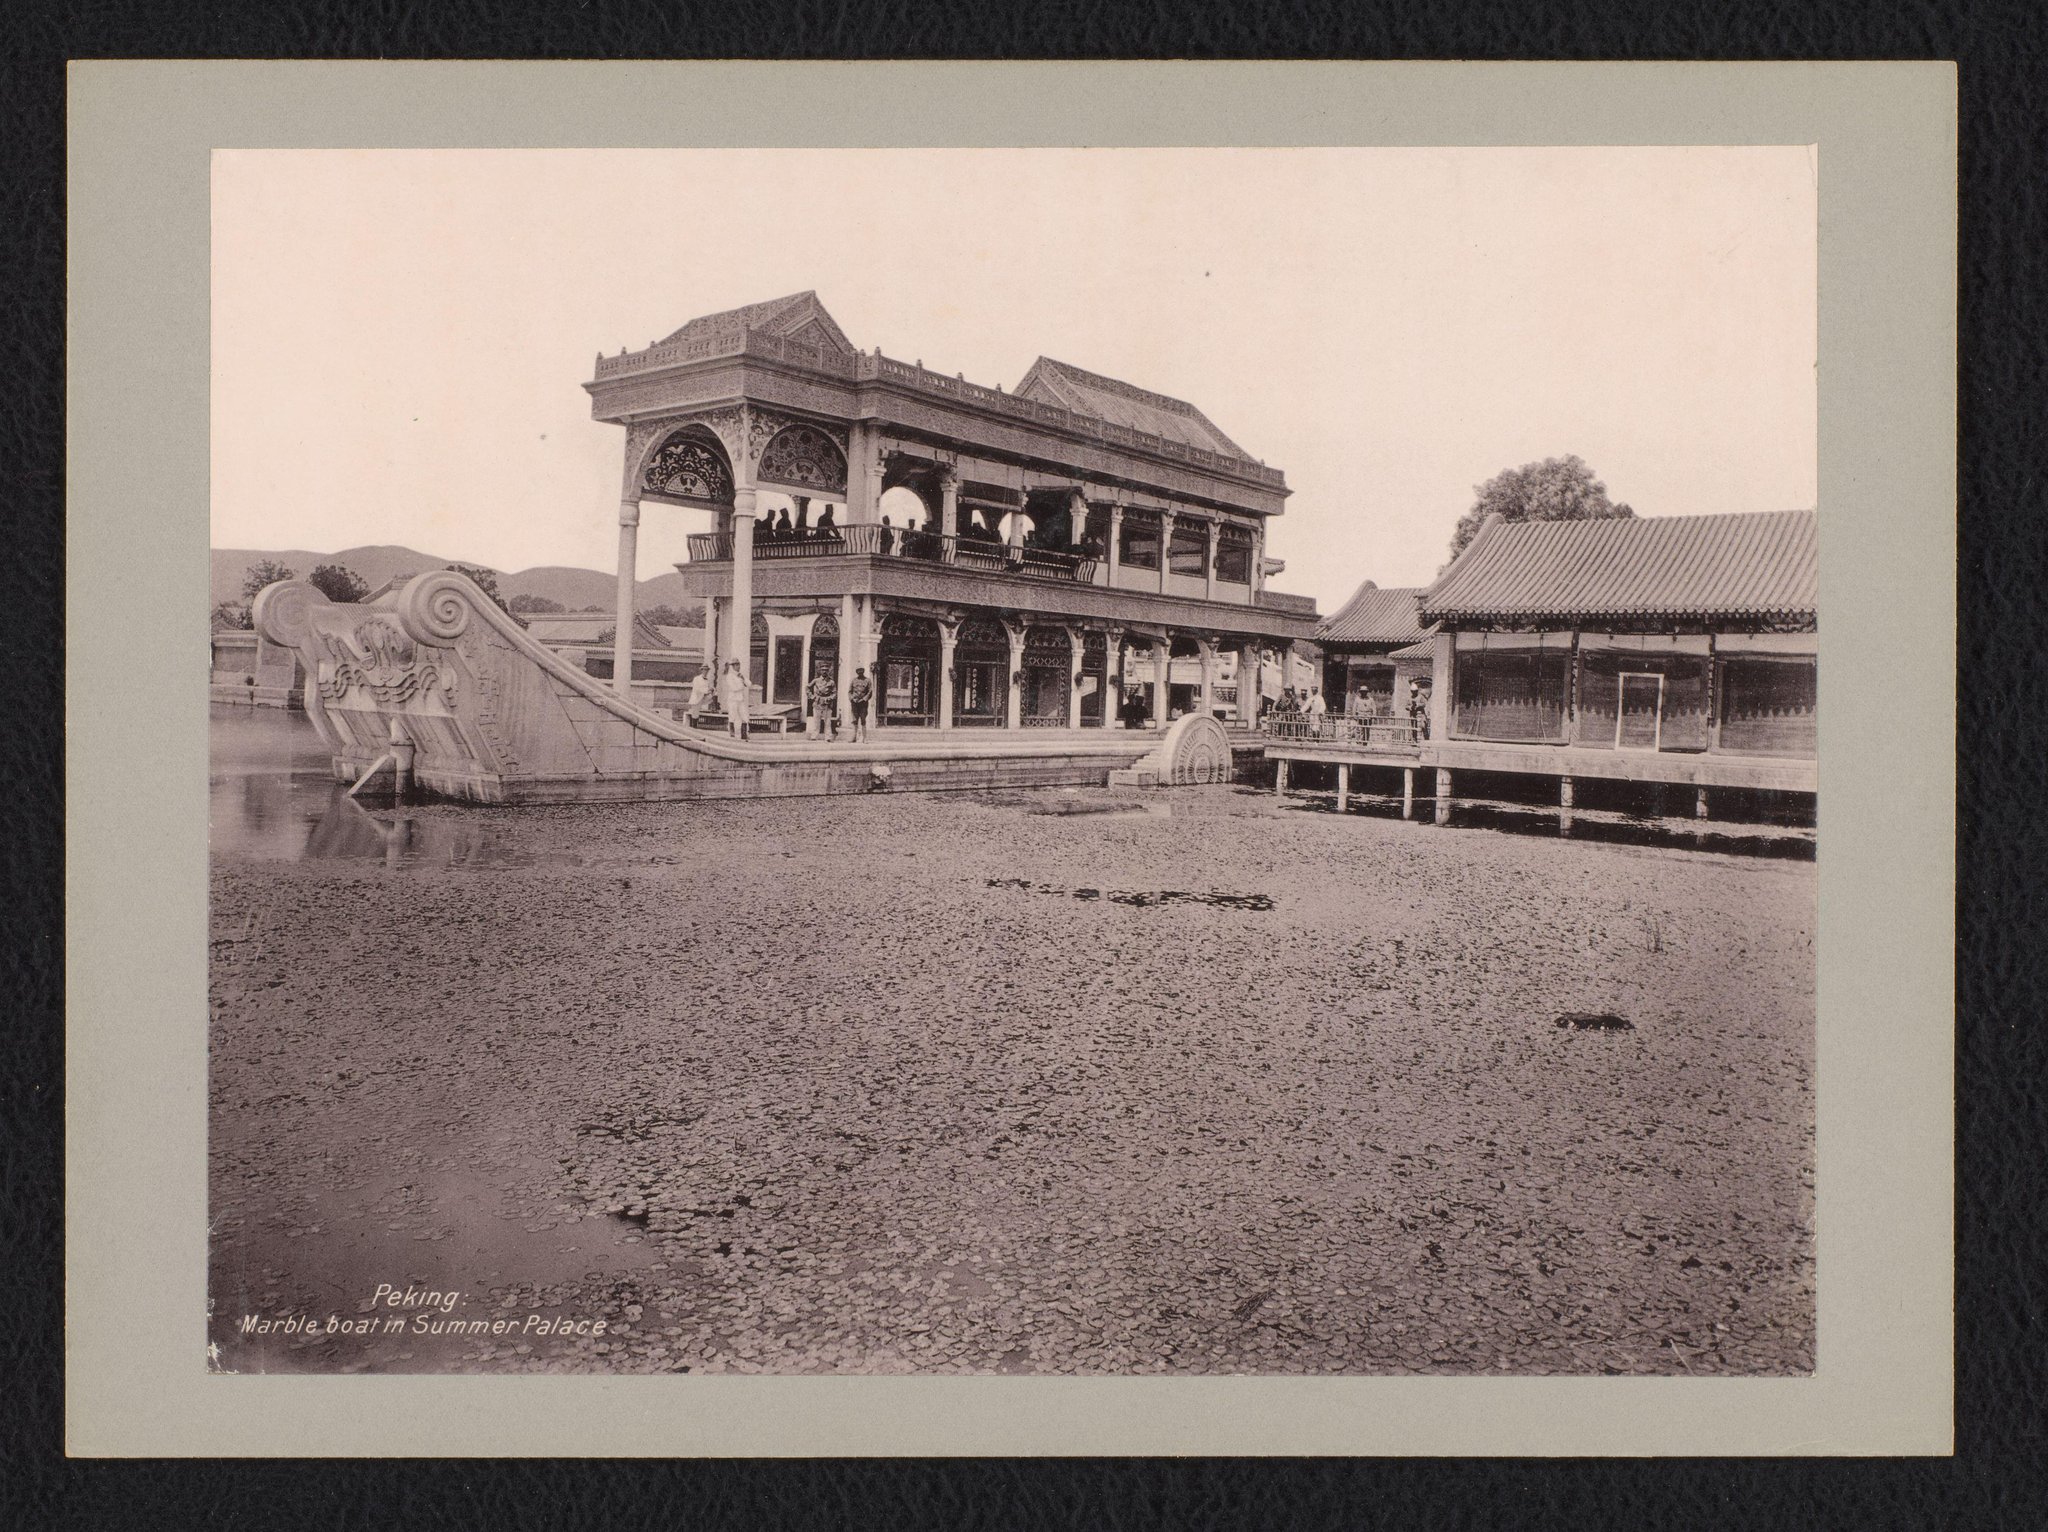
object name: photograph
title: Marmeren boot in Zomerpaleis, Peking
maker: Anonymous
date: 1895-1915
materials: cardboard, photographic support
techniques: photograph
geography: beijing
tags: peking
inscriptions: number: ‘11.’